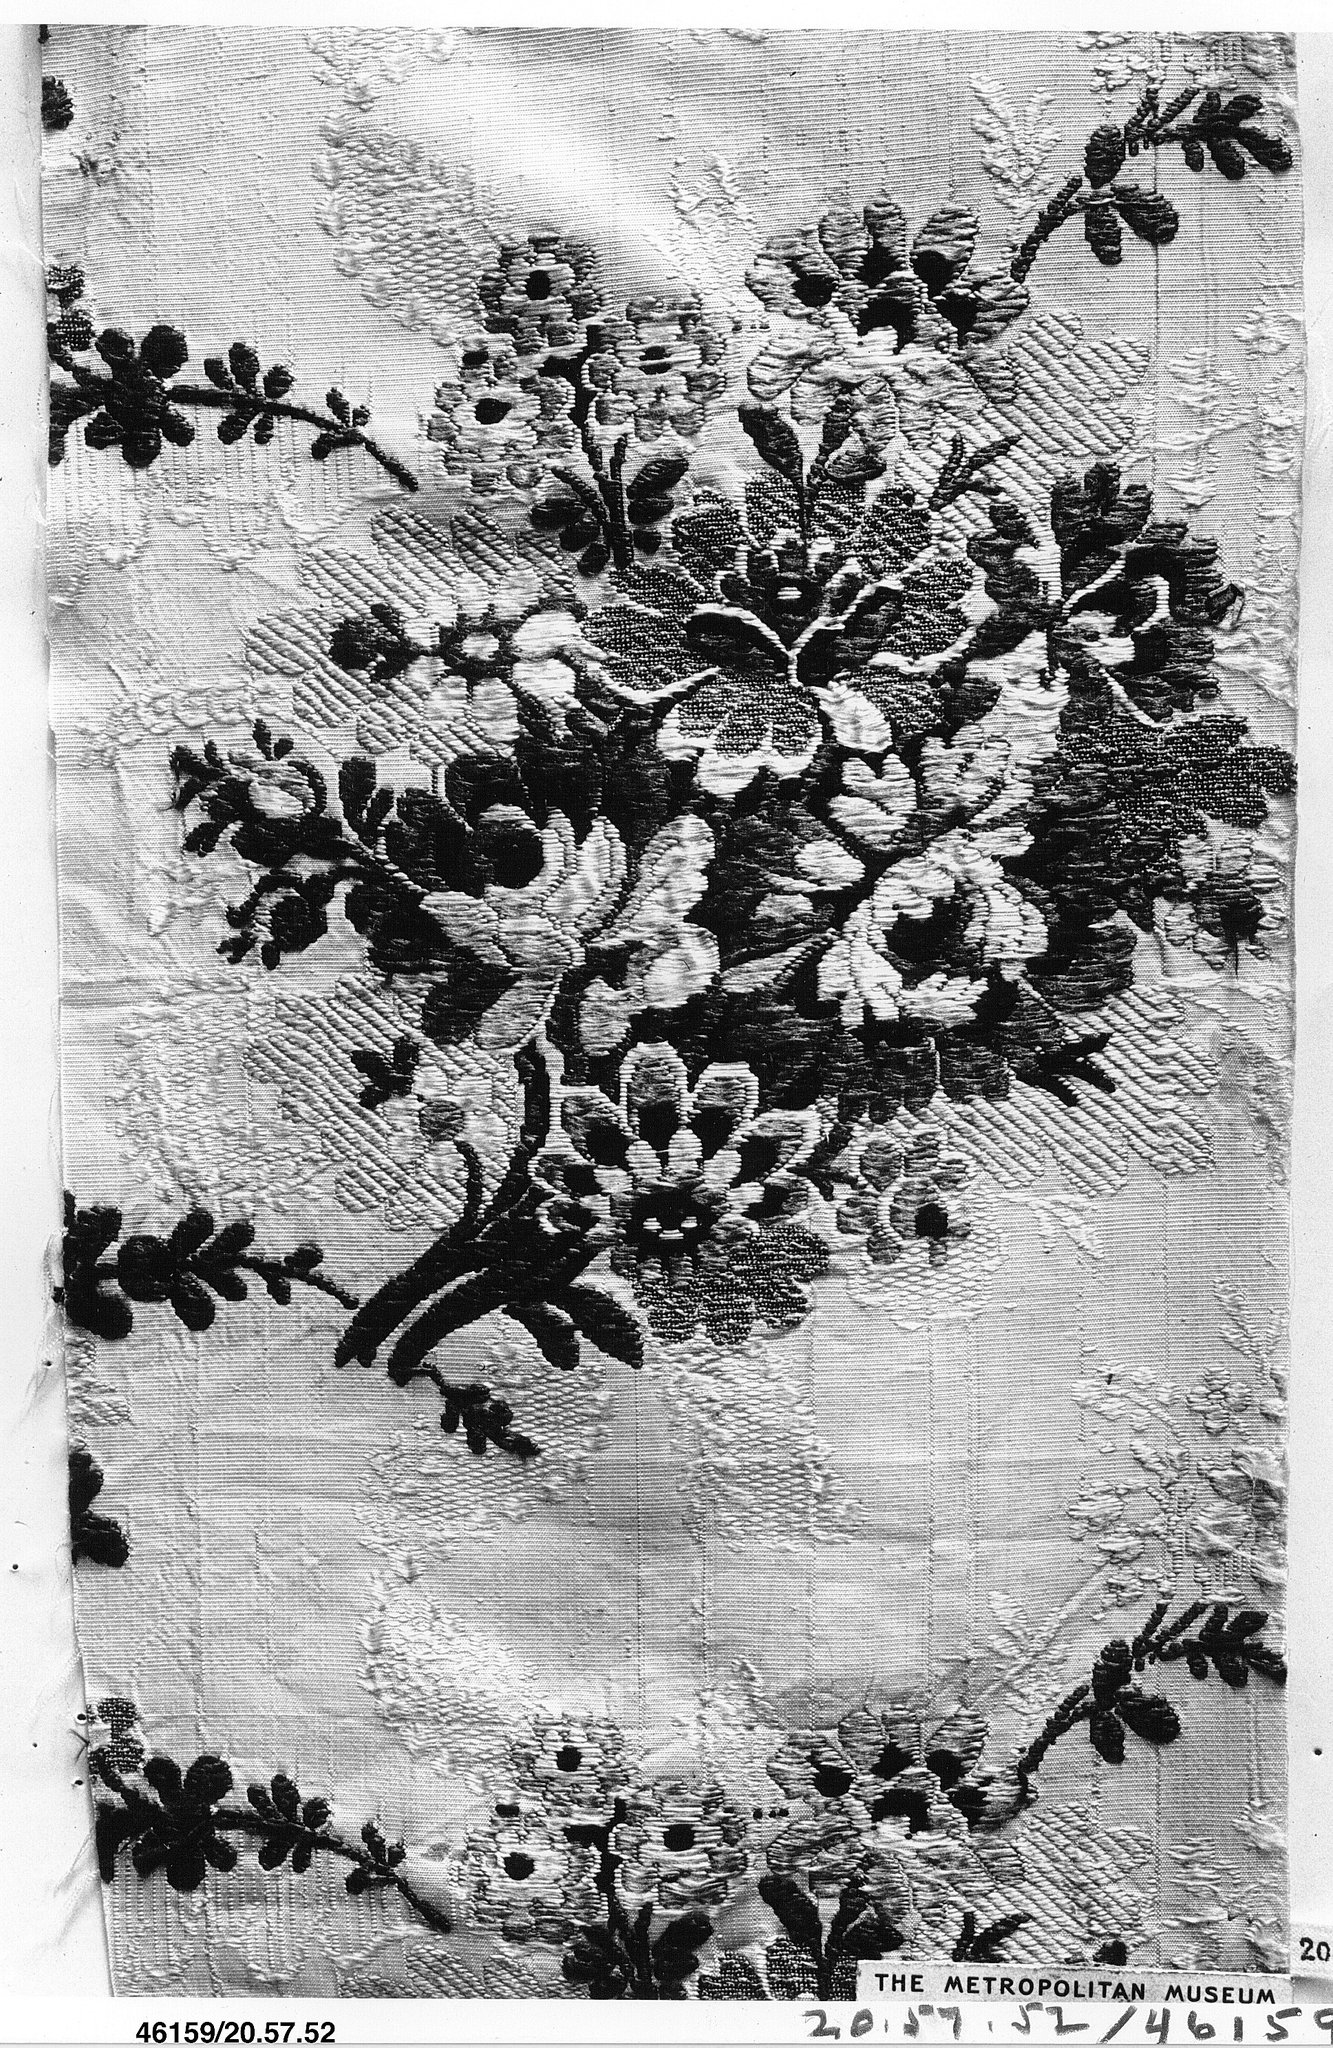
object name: piece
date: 1750-1760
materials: silk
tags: flowers,leaves